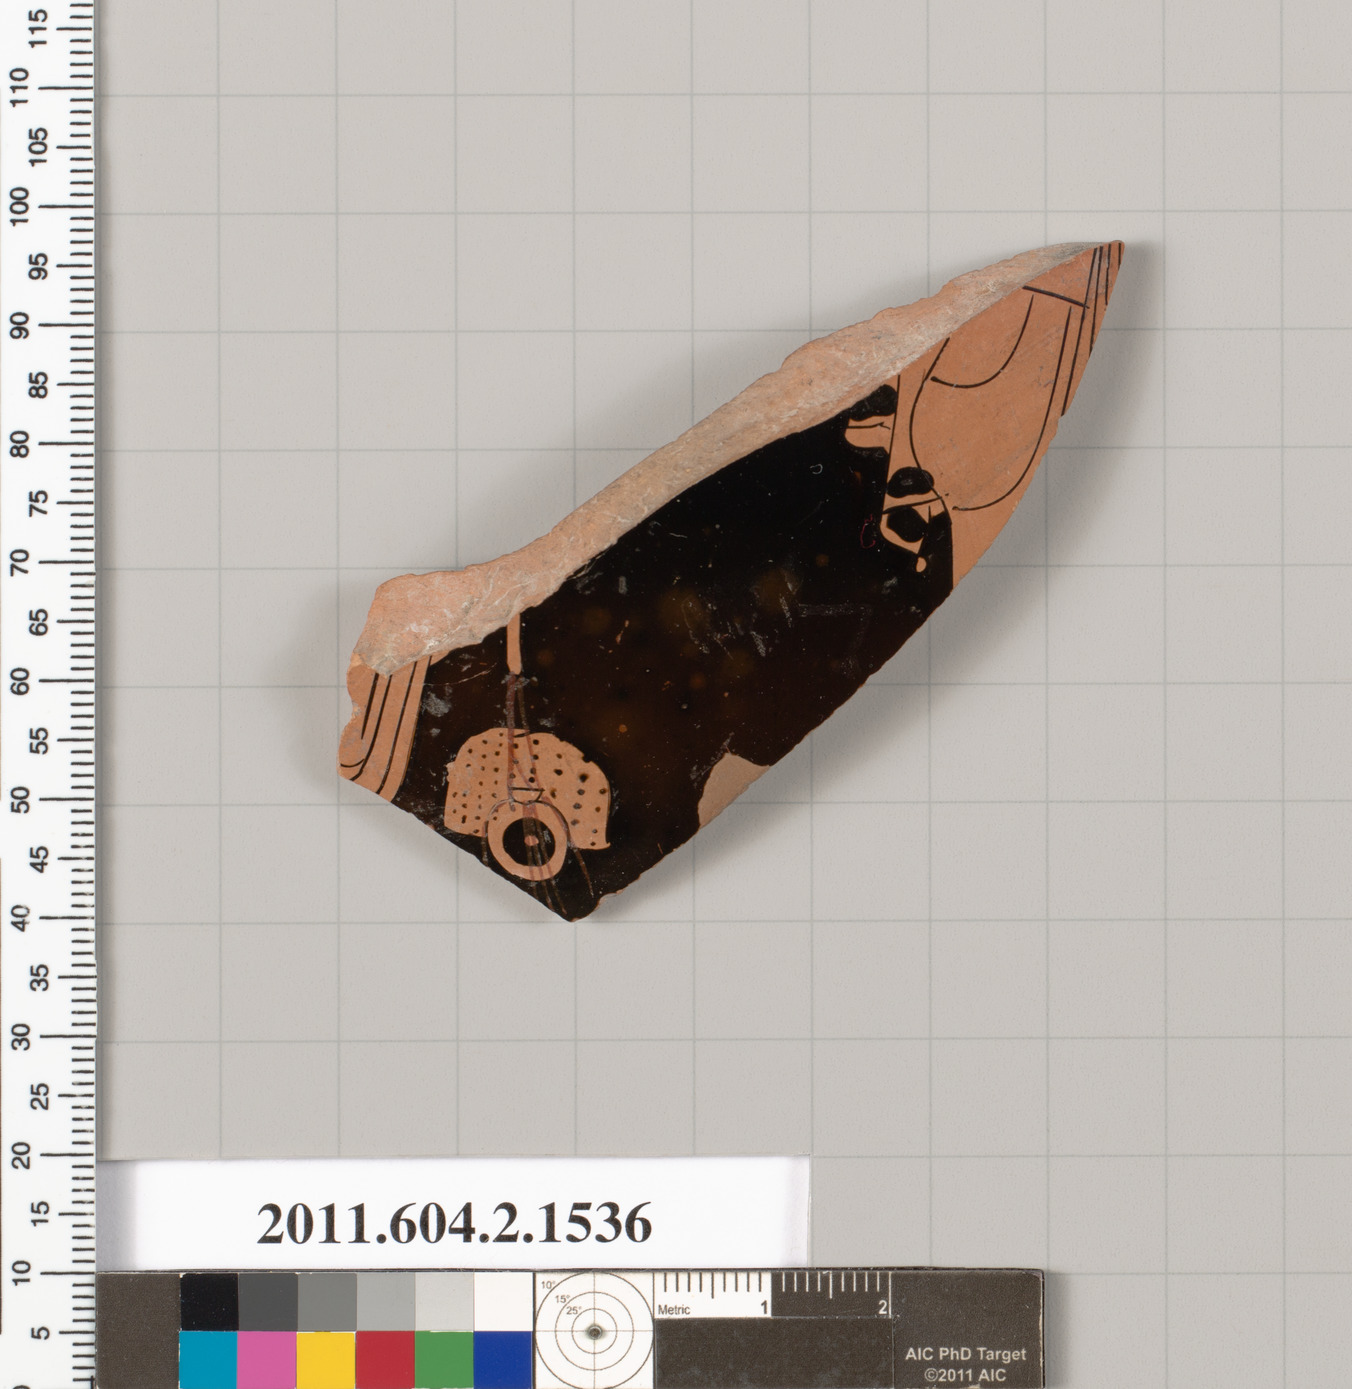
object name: skyphos fragment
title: Terracotta fragment of a skyphos (deep drinking cup)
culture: greek, attic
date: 500-480 BCE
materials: terracotta